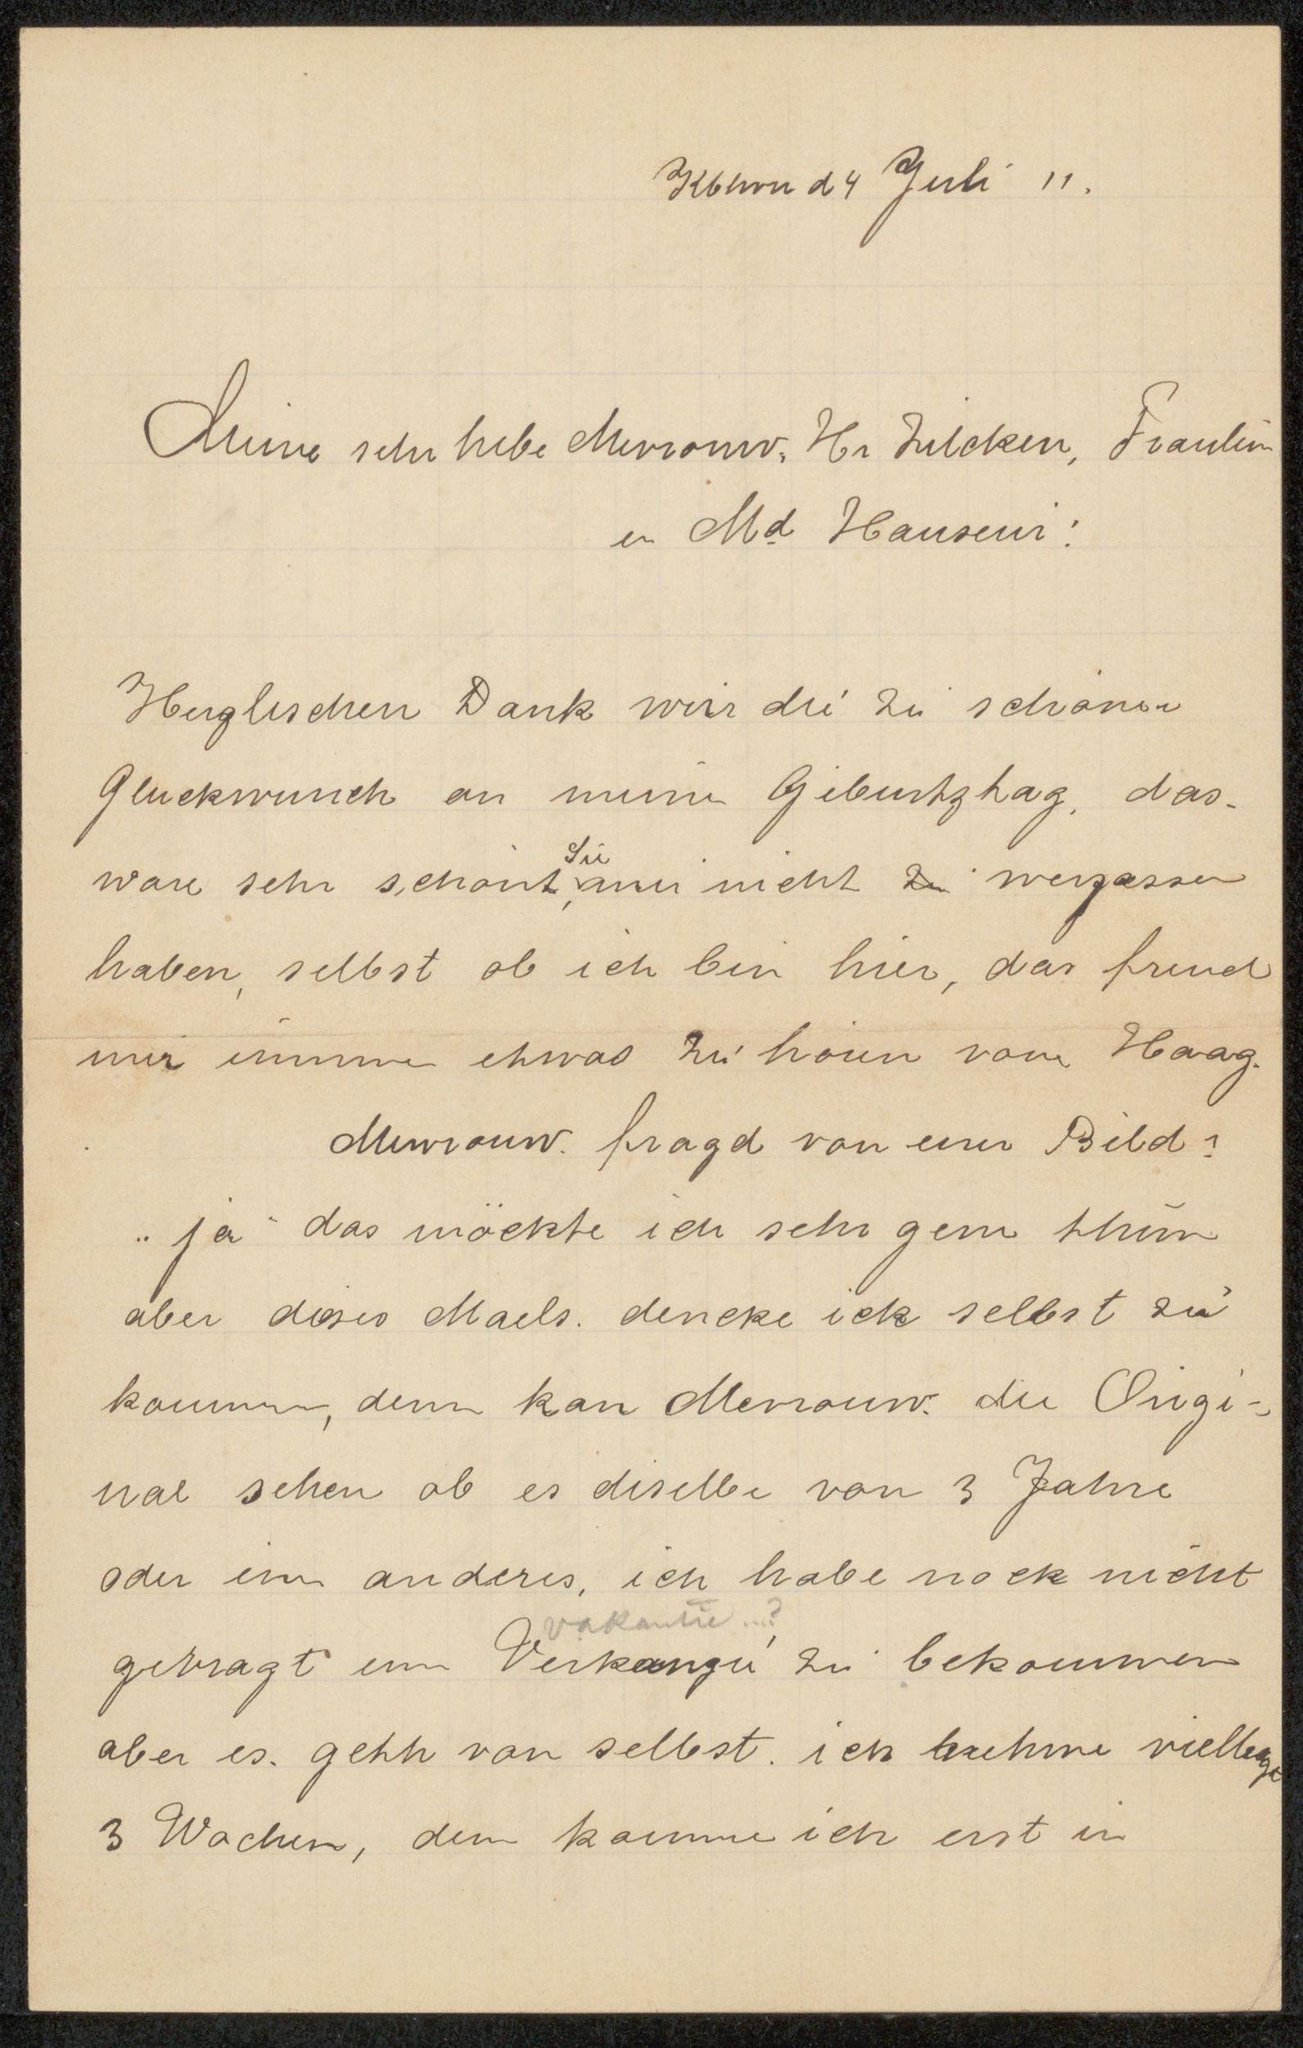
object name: letter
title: Brief aan Henriette Wilhelmina van Baak, Philip Zilcken, Renée Hélène Laure Zilcken et al.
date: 1911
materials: ink, pencil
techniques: pen, writing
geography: copenhagen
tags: voorburg, print maker, renée hélène laure zilcken, henriette wilhelmina van baak, the hague, draughtsman, philip zilcken, drawing, sketch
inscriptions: collector's mark: ‘RPK’